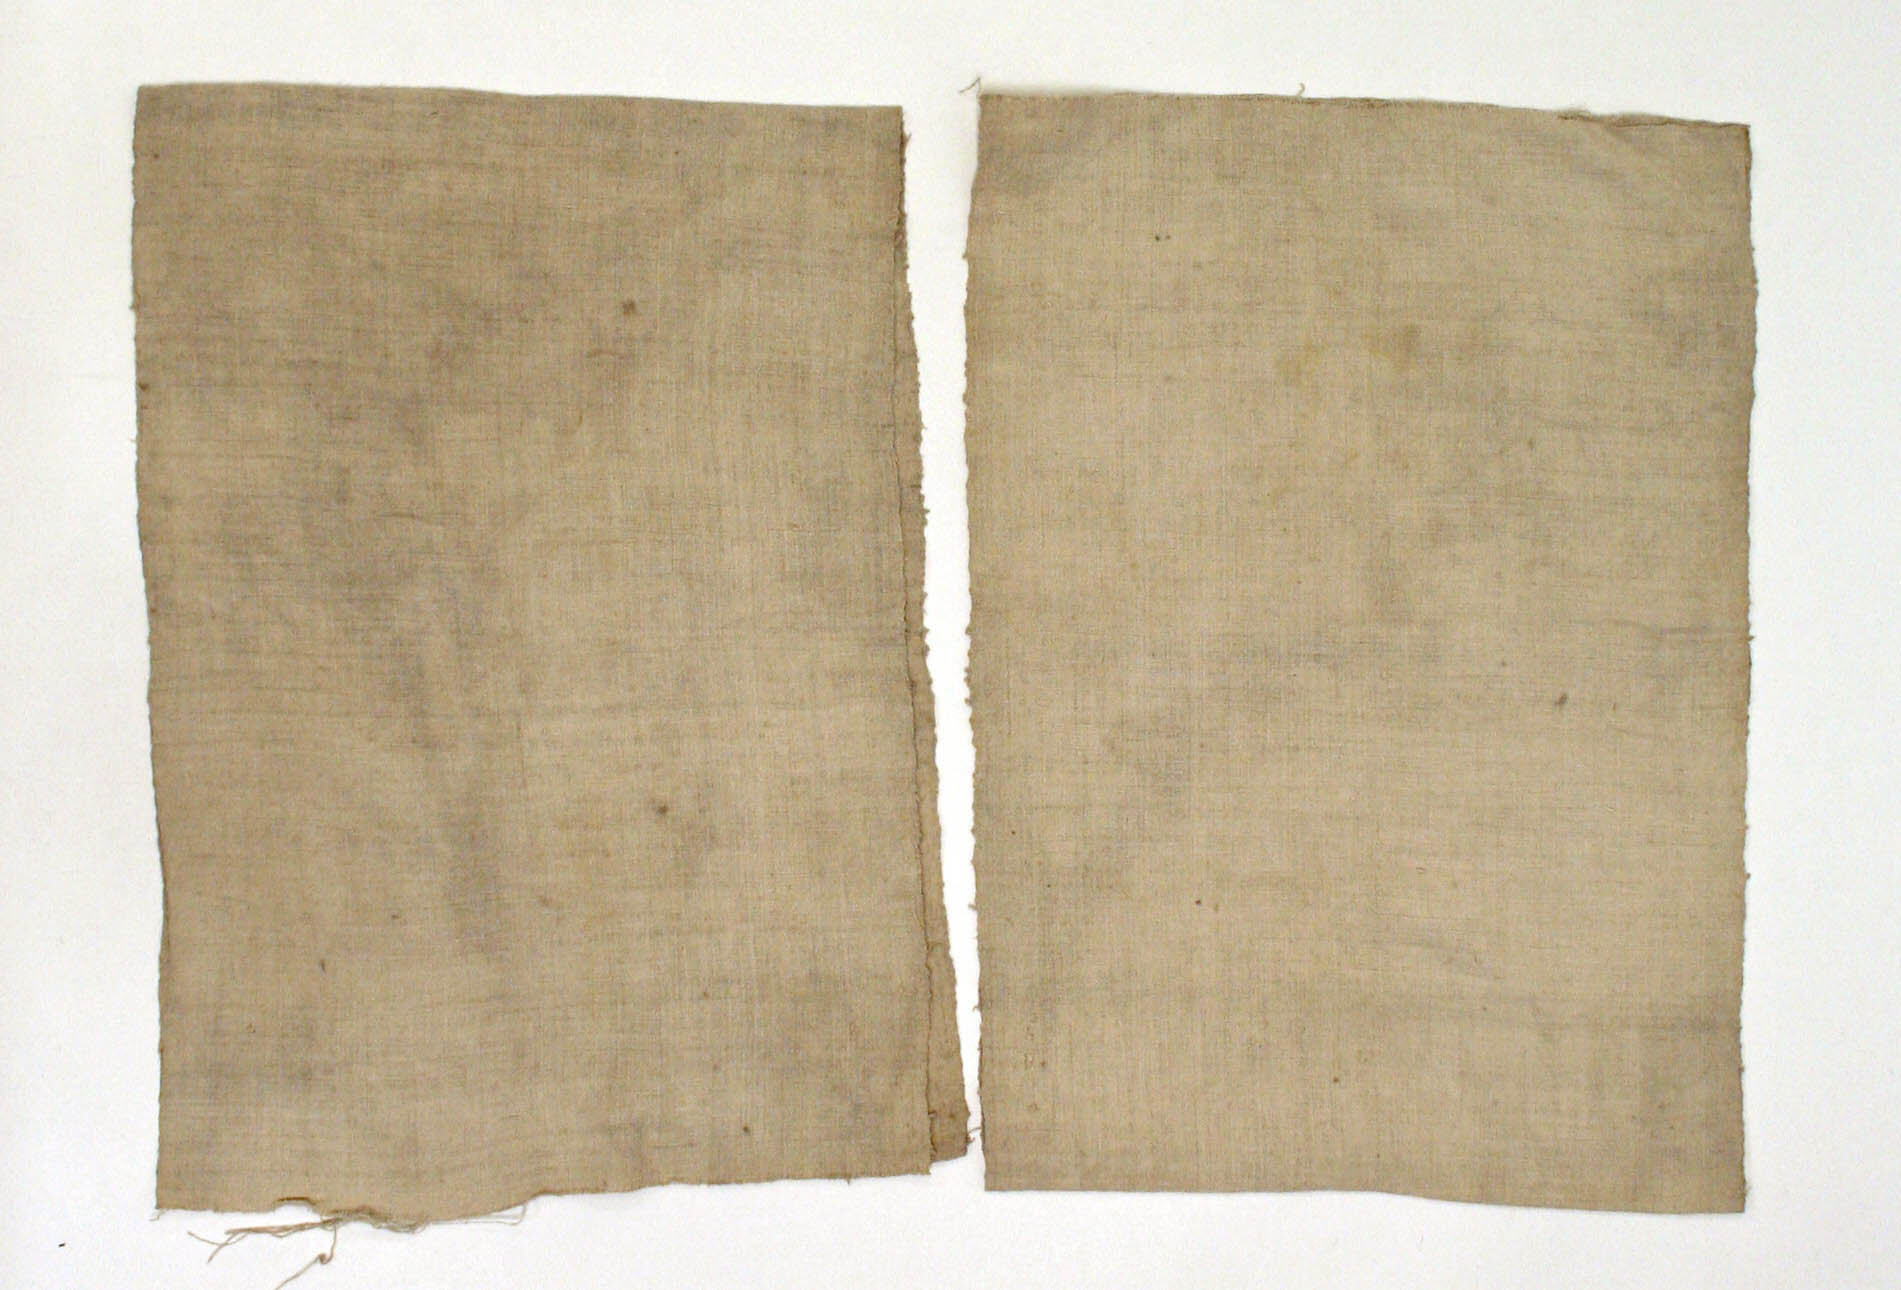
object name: legging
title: Leggings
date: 1801-1900